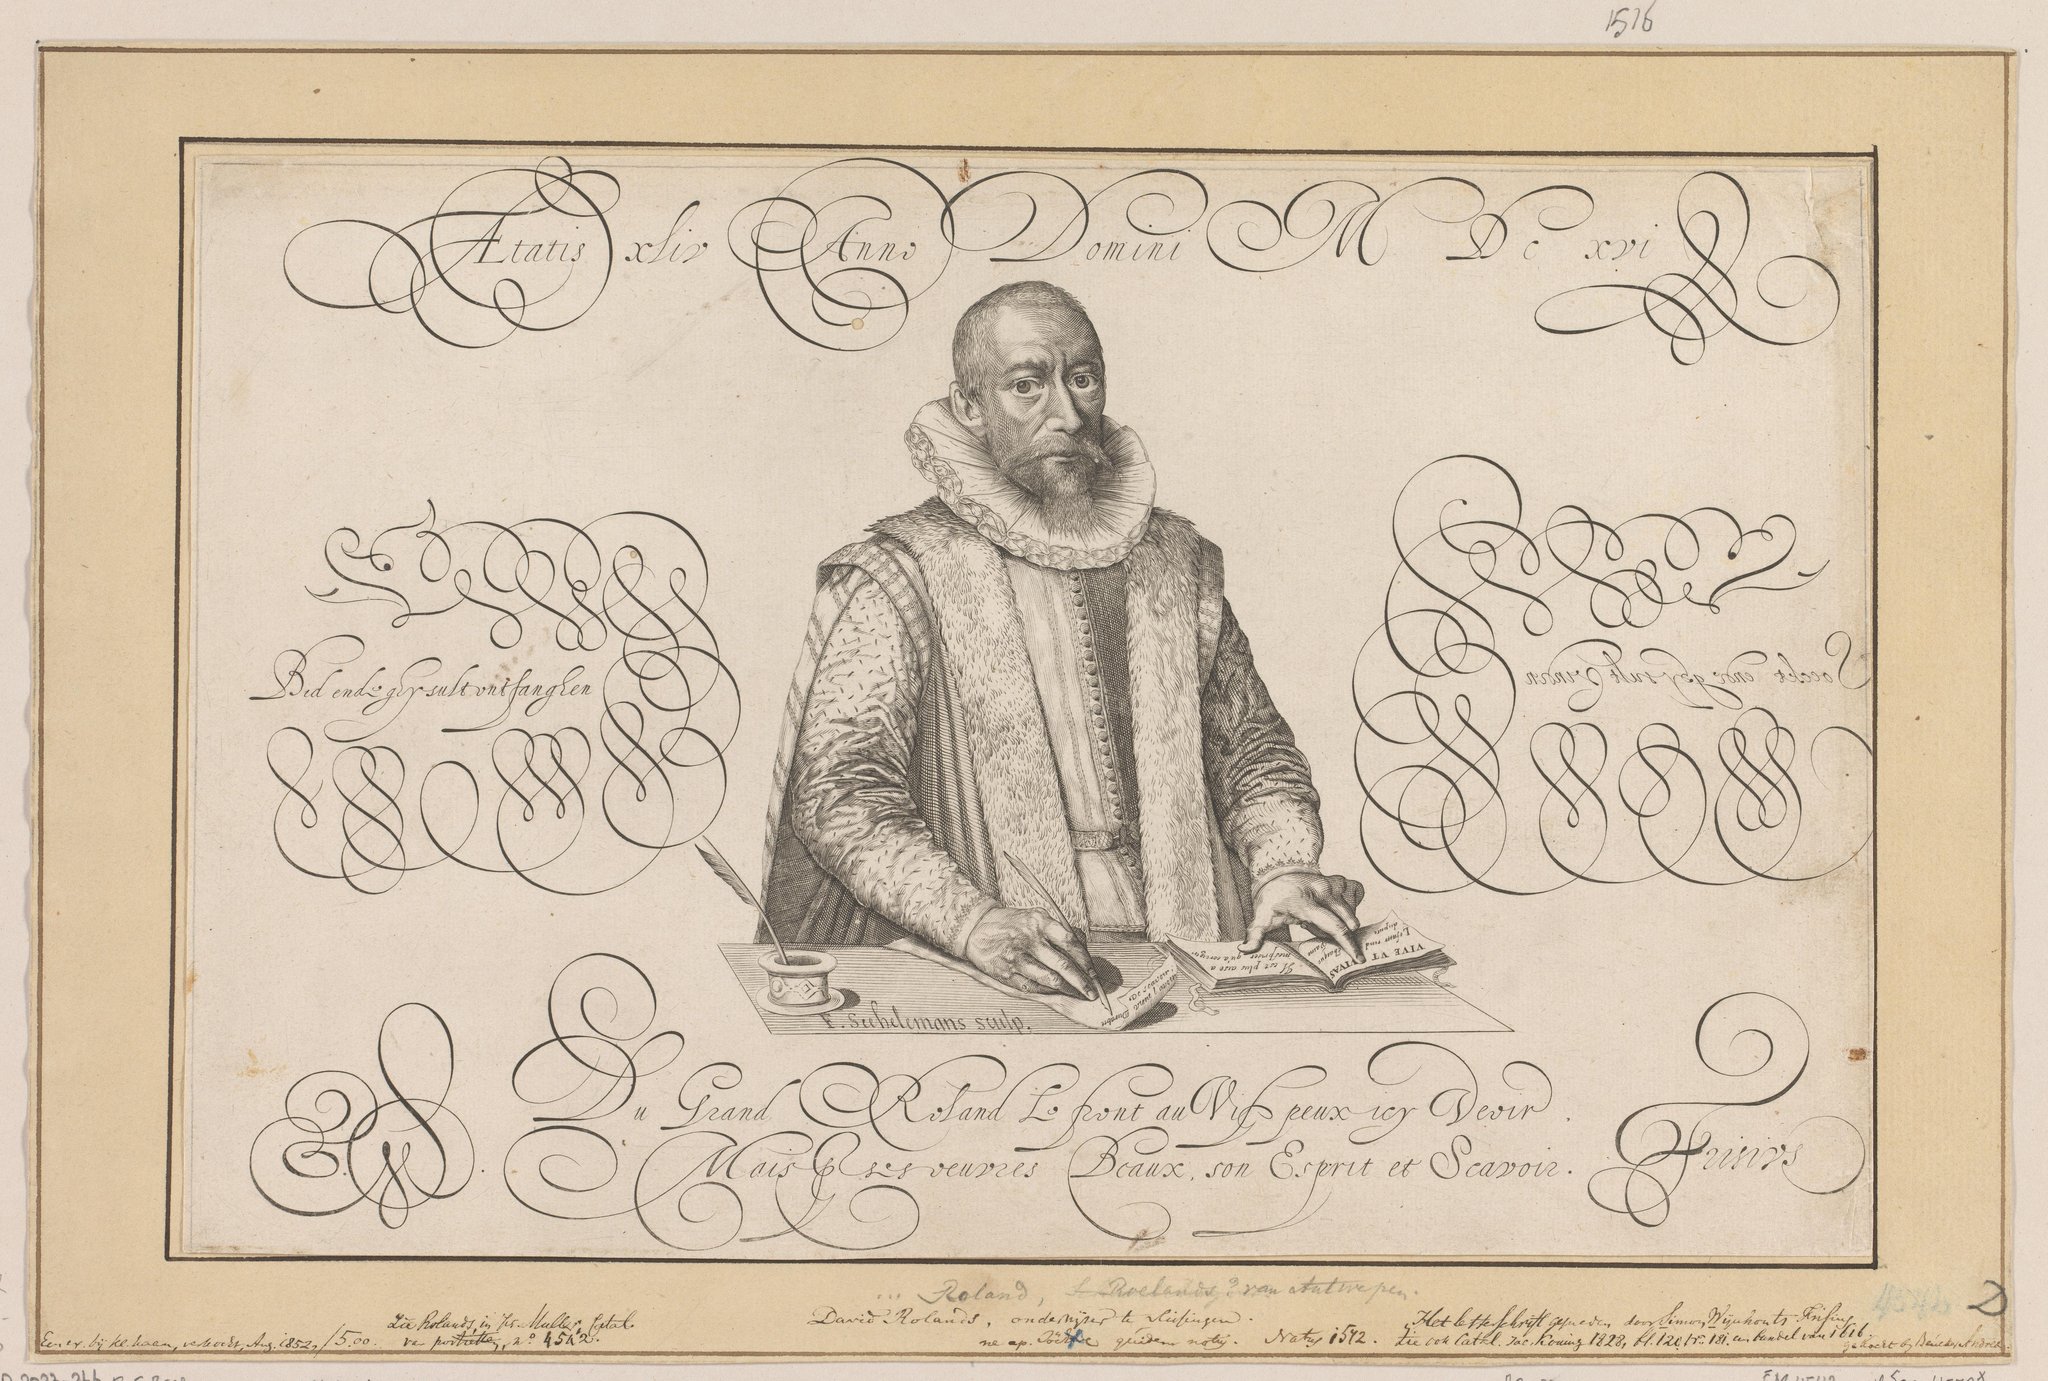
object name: print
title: Portret van David Roelands op 44-jarige leeftijd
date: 1616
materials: paper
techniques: engraving, snipping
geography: middelburg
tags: antwerp, david roelands, historical persons, calligraphy (+ portrait of scholar, scientist)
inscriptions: collector's mark: Lugt 2228, inscription: ‘Roland, Roelands ? (...) bei Beucker (?) Andrea.’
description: Prent ook gebruikt in: Roelands, David. 't Magazijn oft pac-huys der loffelycker penn-const. Vlissingen: s.n., 1616.